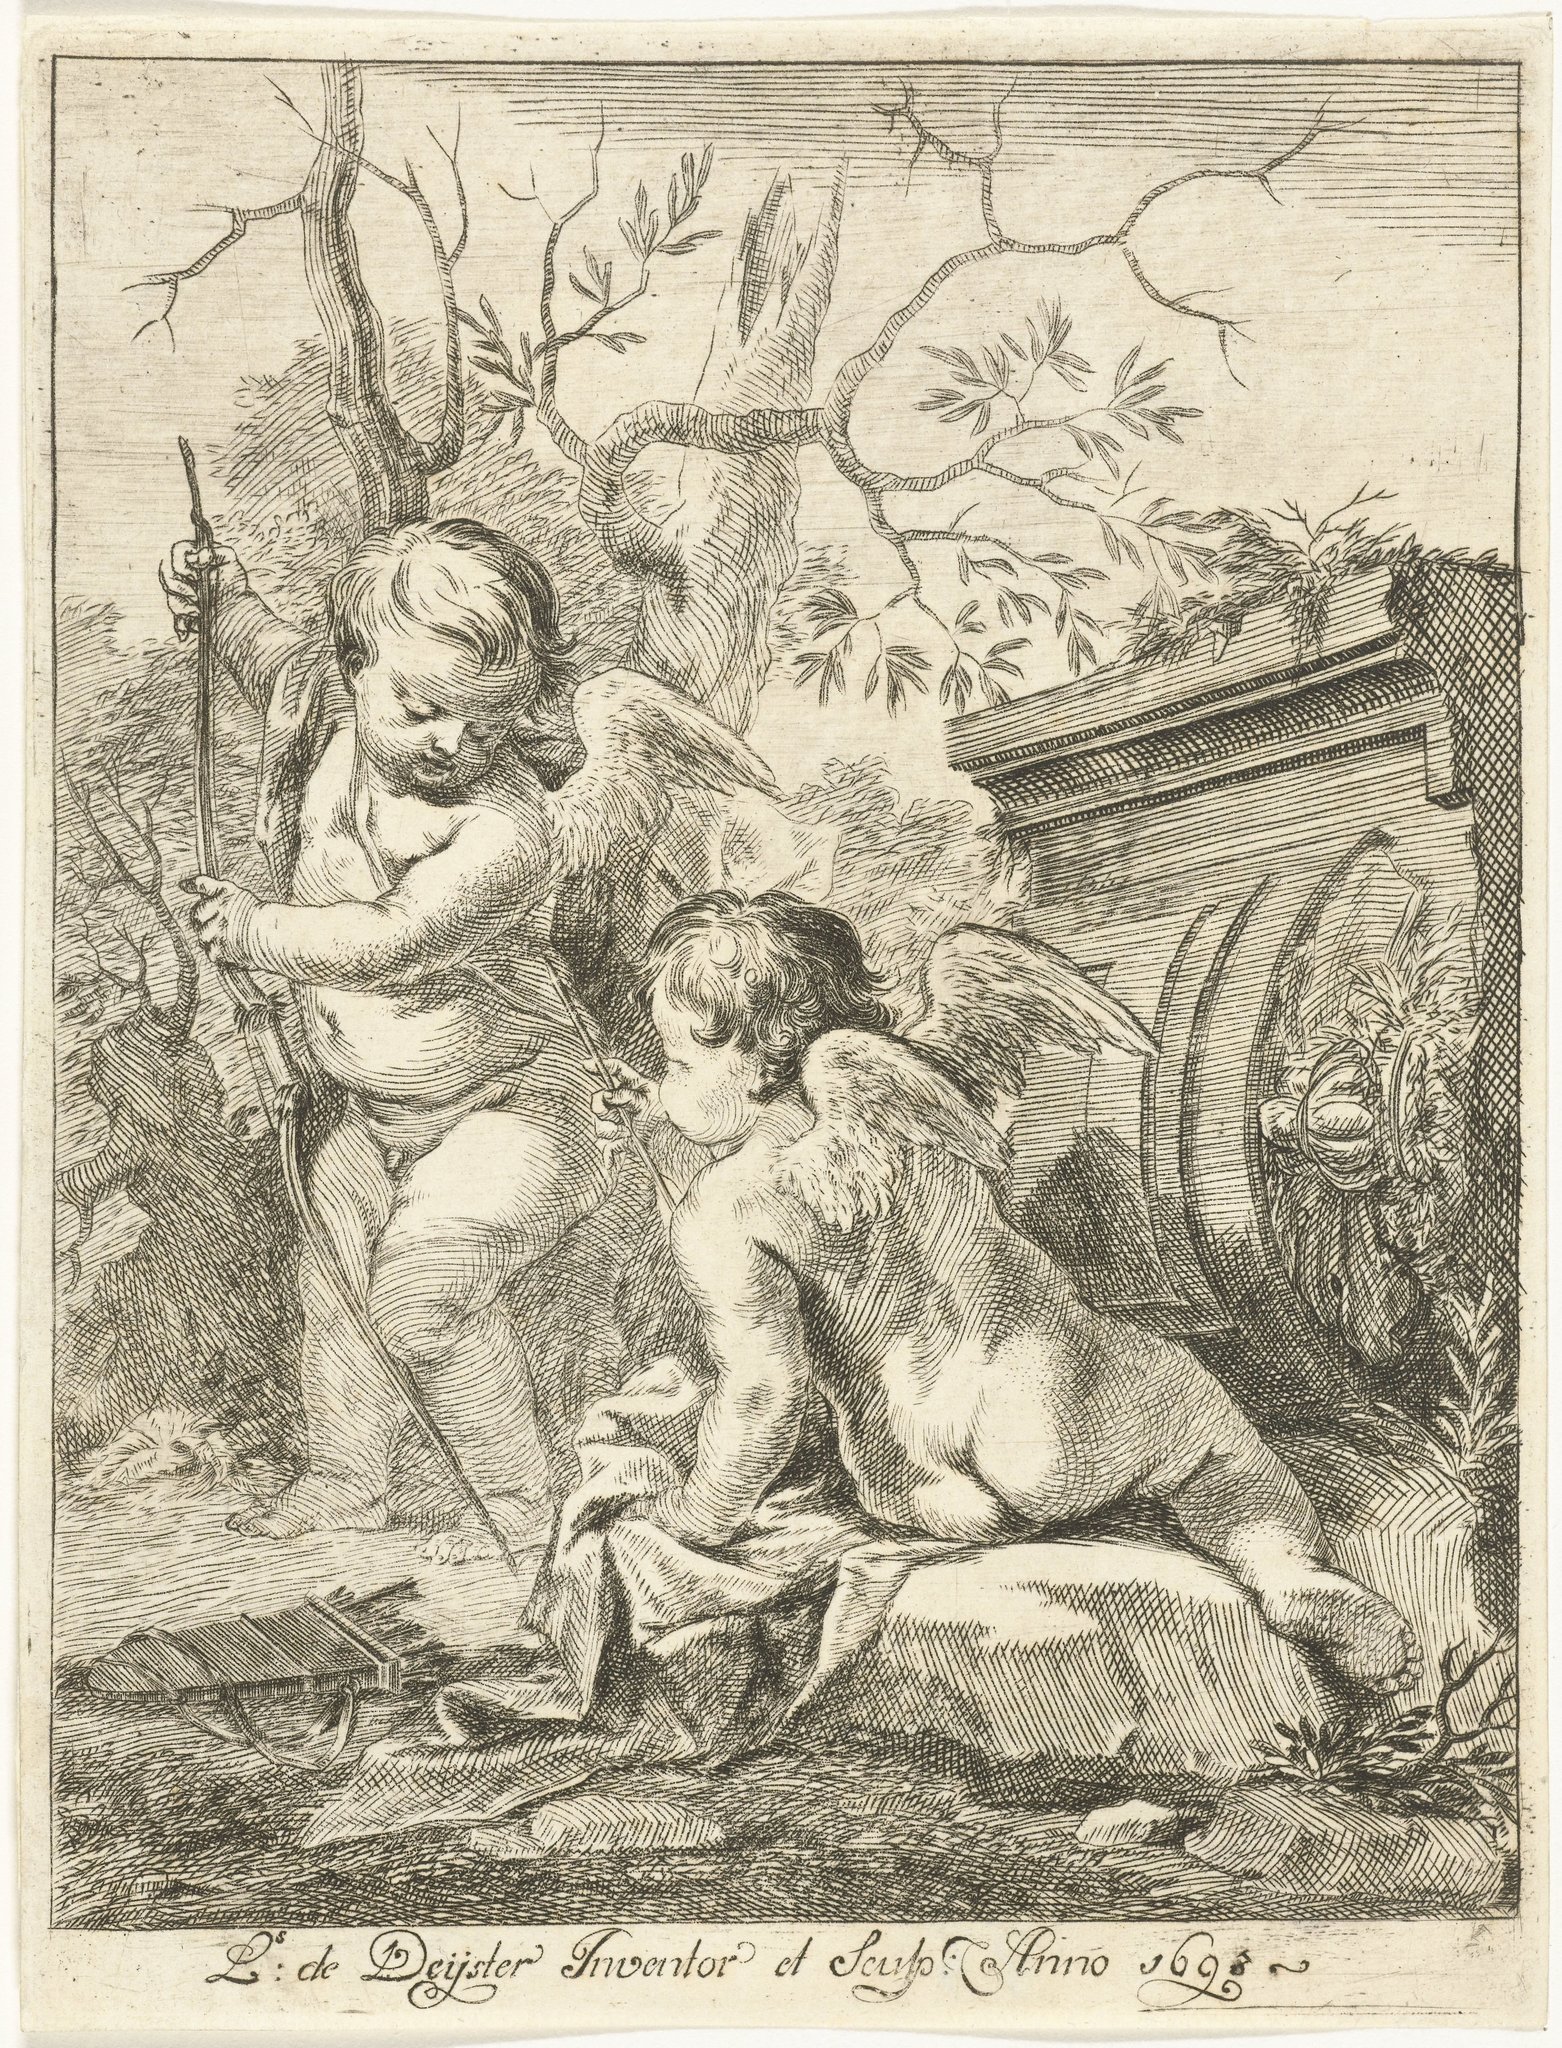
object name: print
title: Twee amors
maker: louis de deyster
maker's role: draughtsman, painter, print maker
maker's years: 1656-1711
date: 1693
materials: paper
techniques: etching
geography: southern netherlands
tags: cupids: 'amores', 'amoretti', 'putti'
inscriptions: collector's mark: Lugt 240